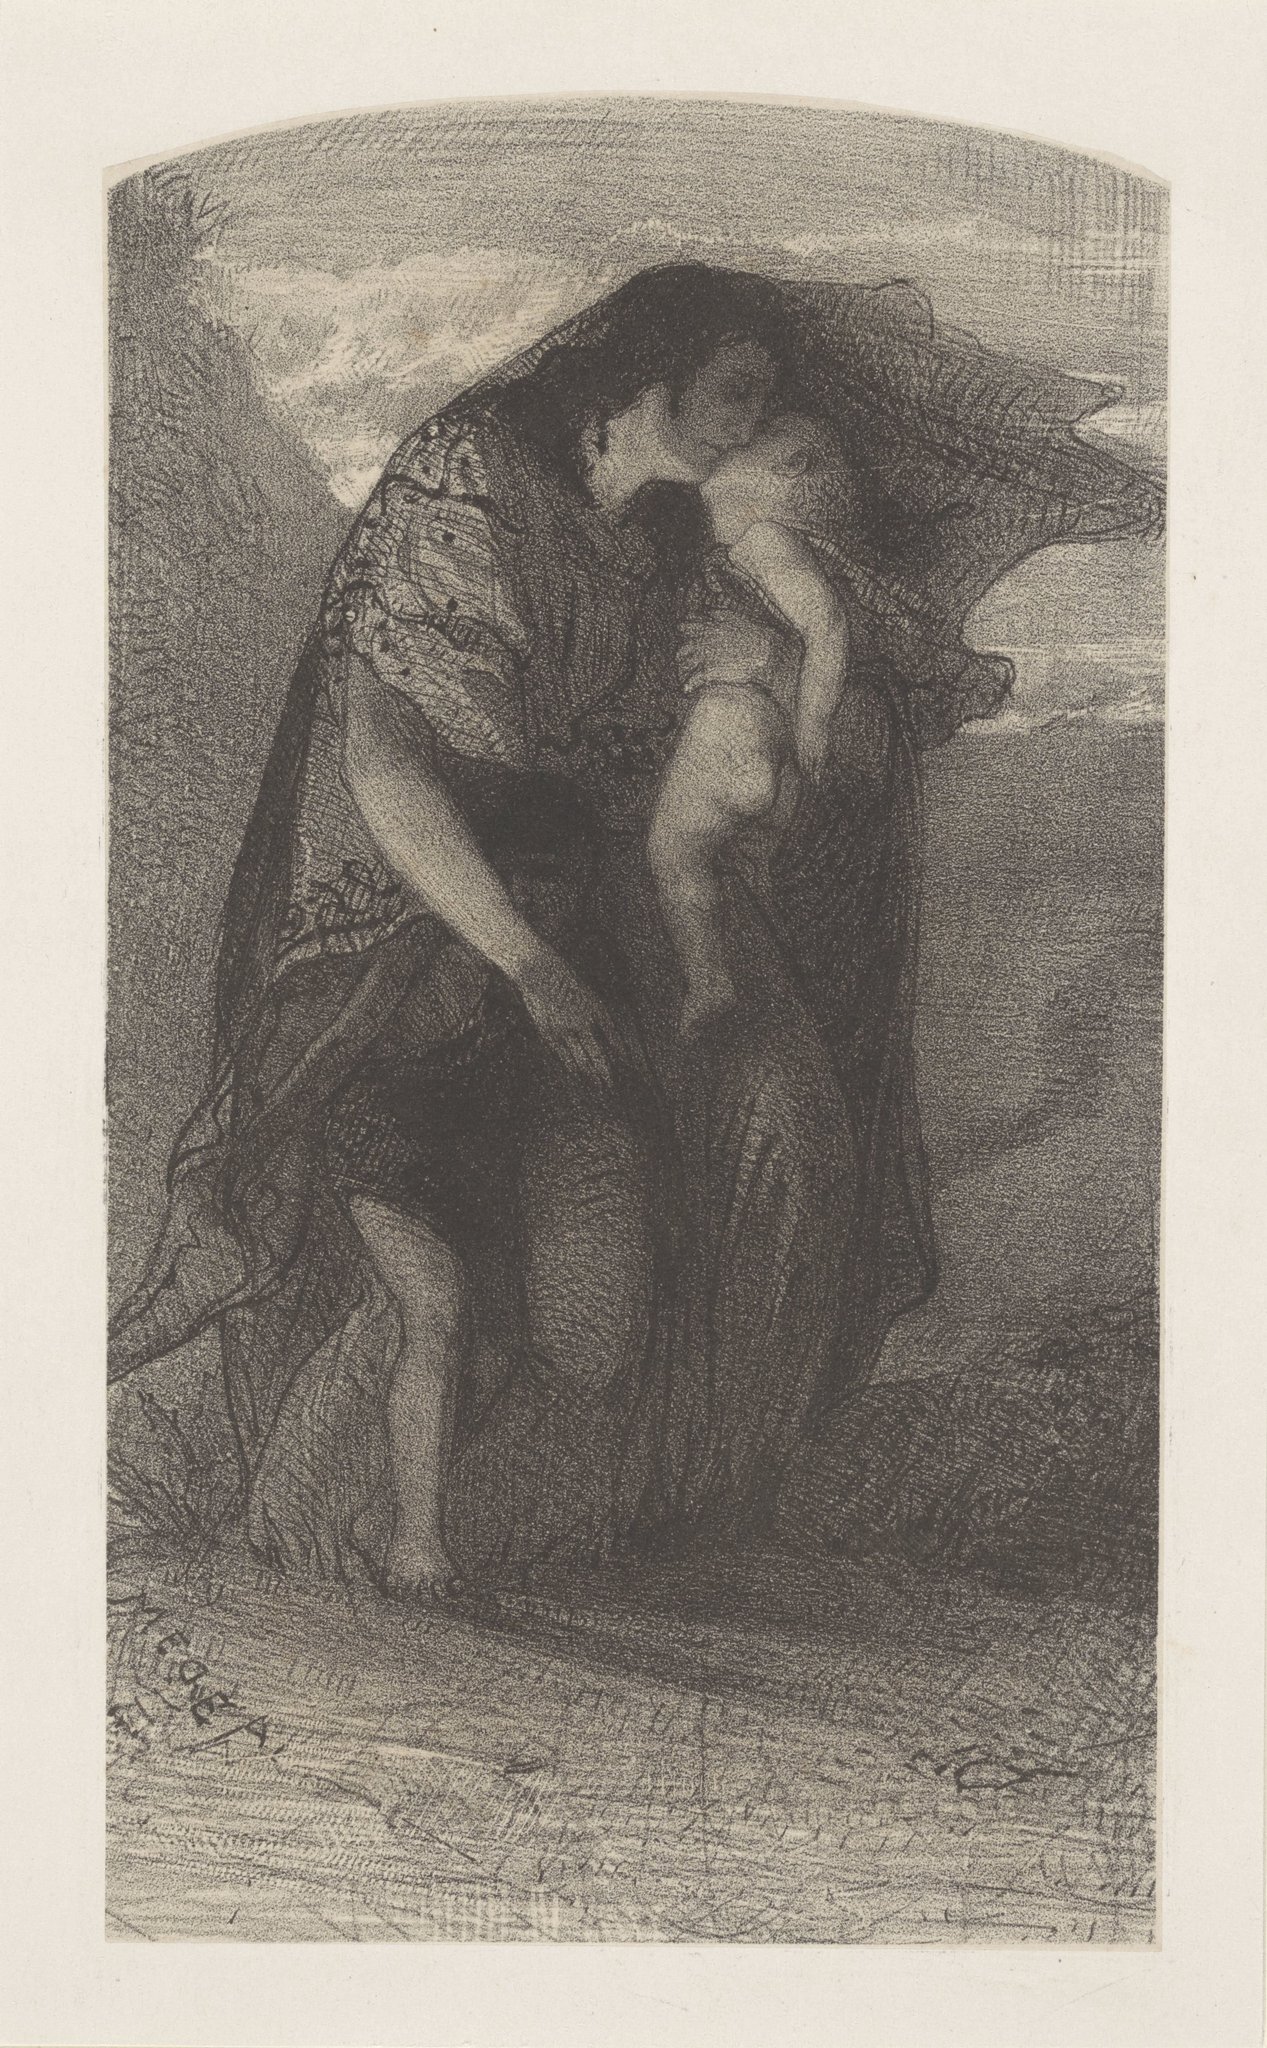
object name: print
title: Medea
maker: august allebé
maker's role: draughtsman, print maker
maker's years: 1838-1927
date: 1848-1909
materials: paper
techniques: lithograph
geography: amsterdam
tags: mother and son(s) (family group), medea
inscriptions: inscription: ‘Naar aanleiding van Ristori Medea / Leidsche plein 1860?’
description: Medea loopt met haar zonen door een landschap. Haar jongste zoon draagt zij op haar linkerarm. Met haar rechterarm drukt zij haar oudste zoon tegen zich aan. Ze is in loshangende gewaden gehuld en een sluier waait over hen heen.